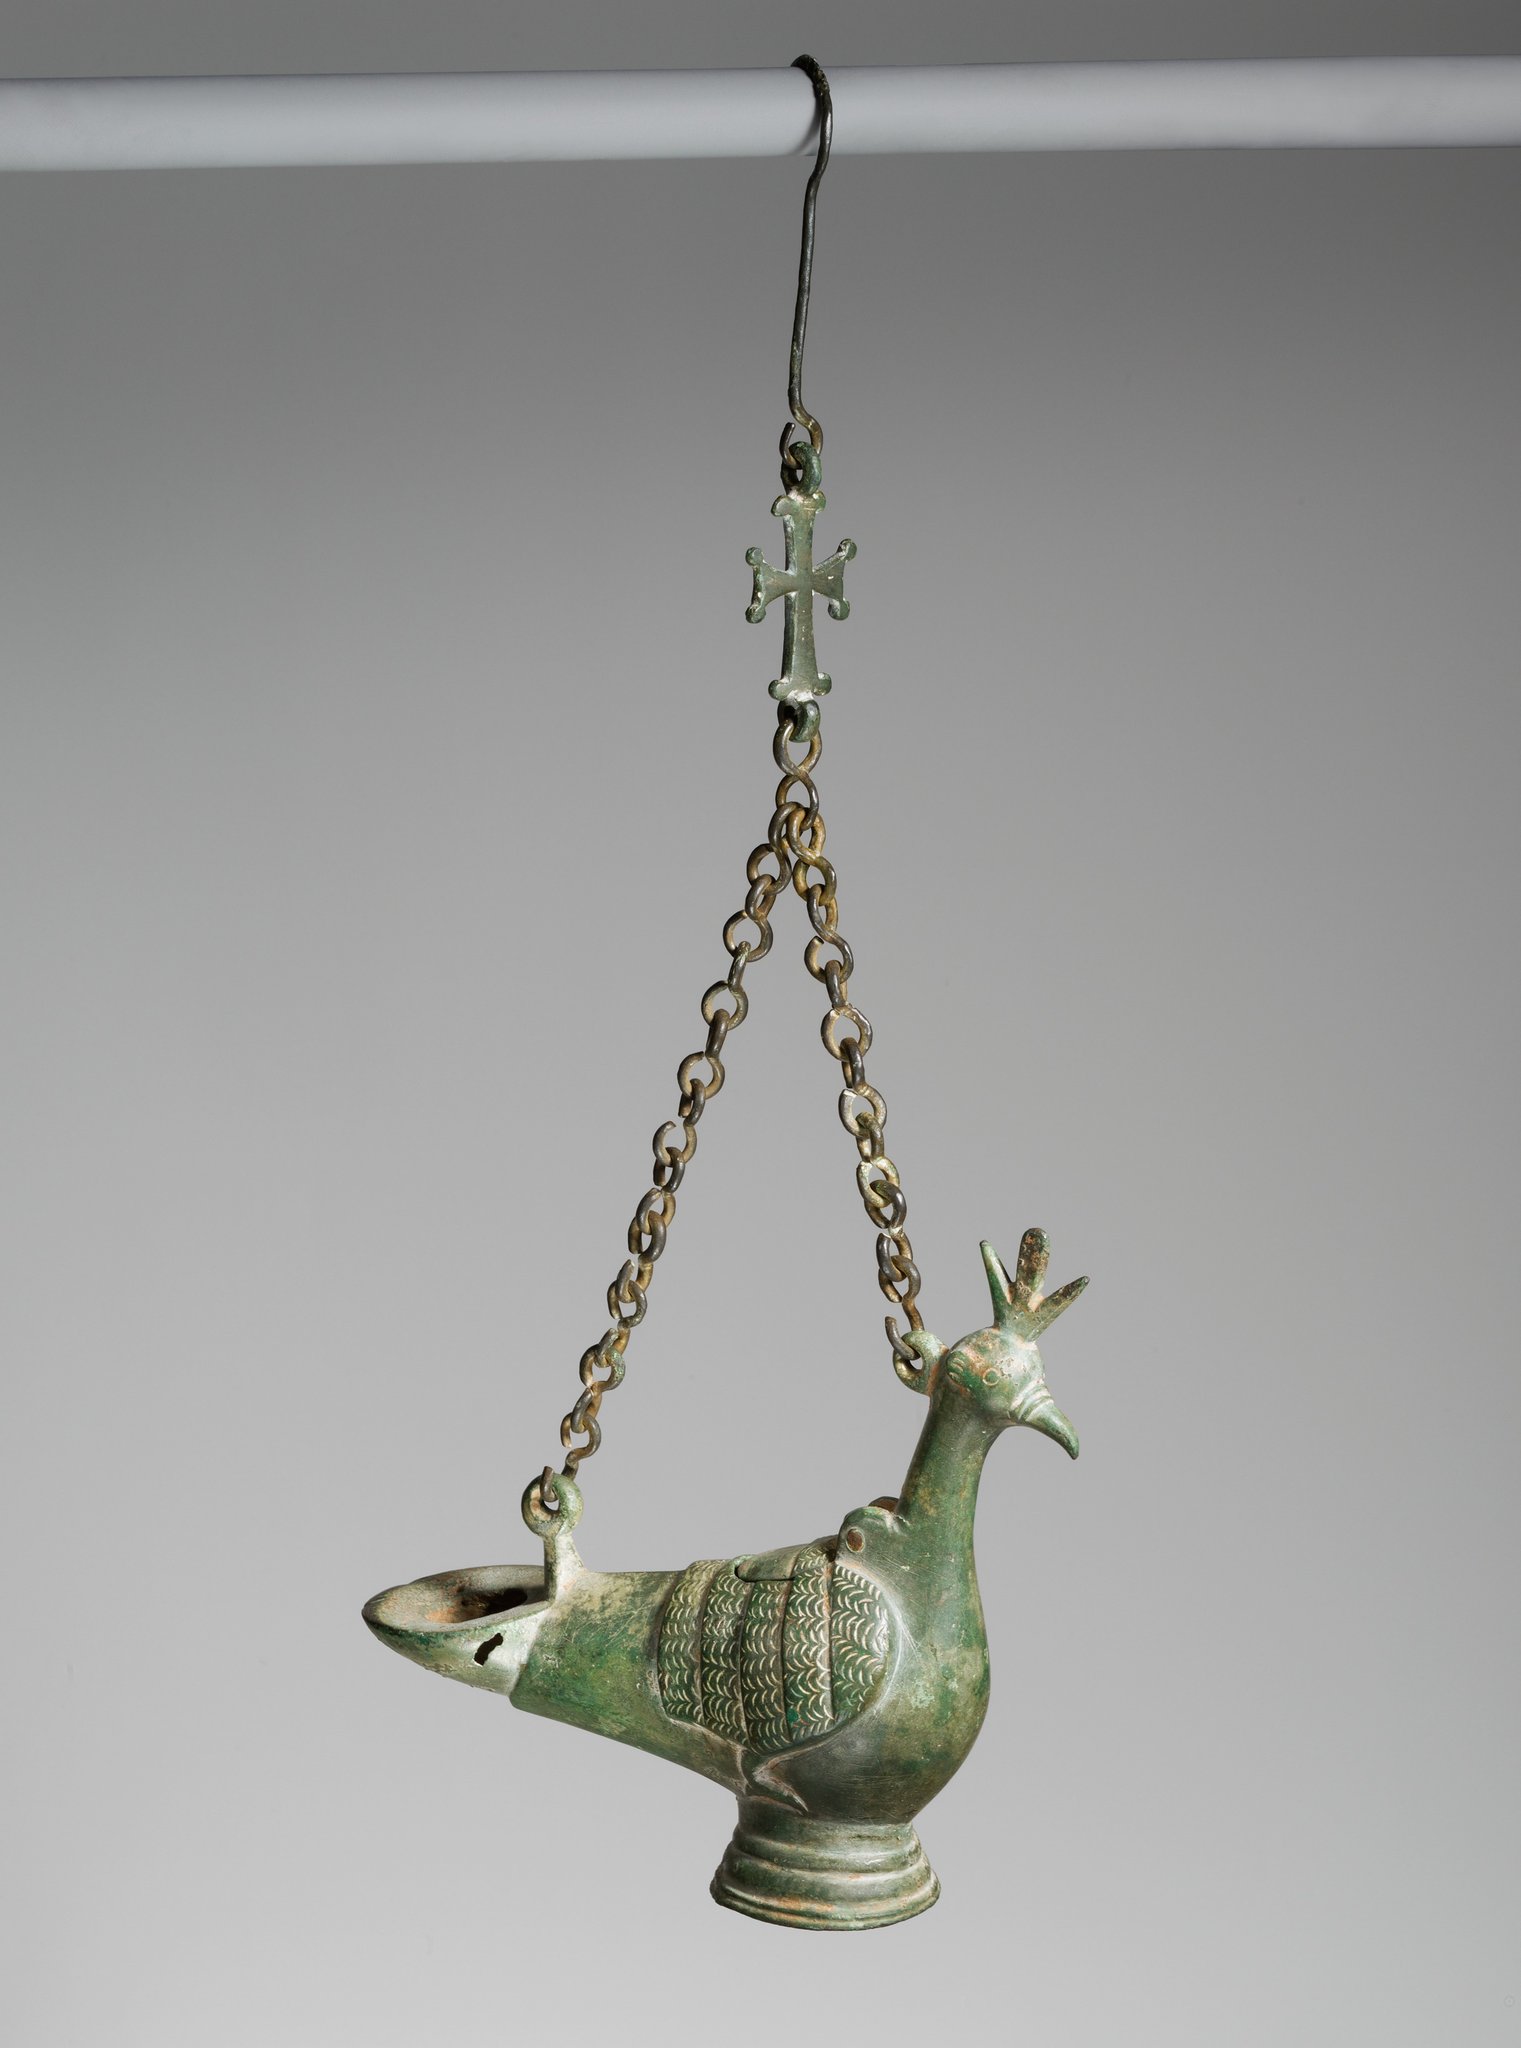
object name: lamp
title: Hanging Lamp in the Form of a Peacock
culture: byzantine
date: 501-700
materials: copper alloy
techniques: casting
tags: peacocks